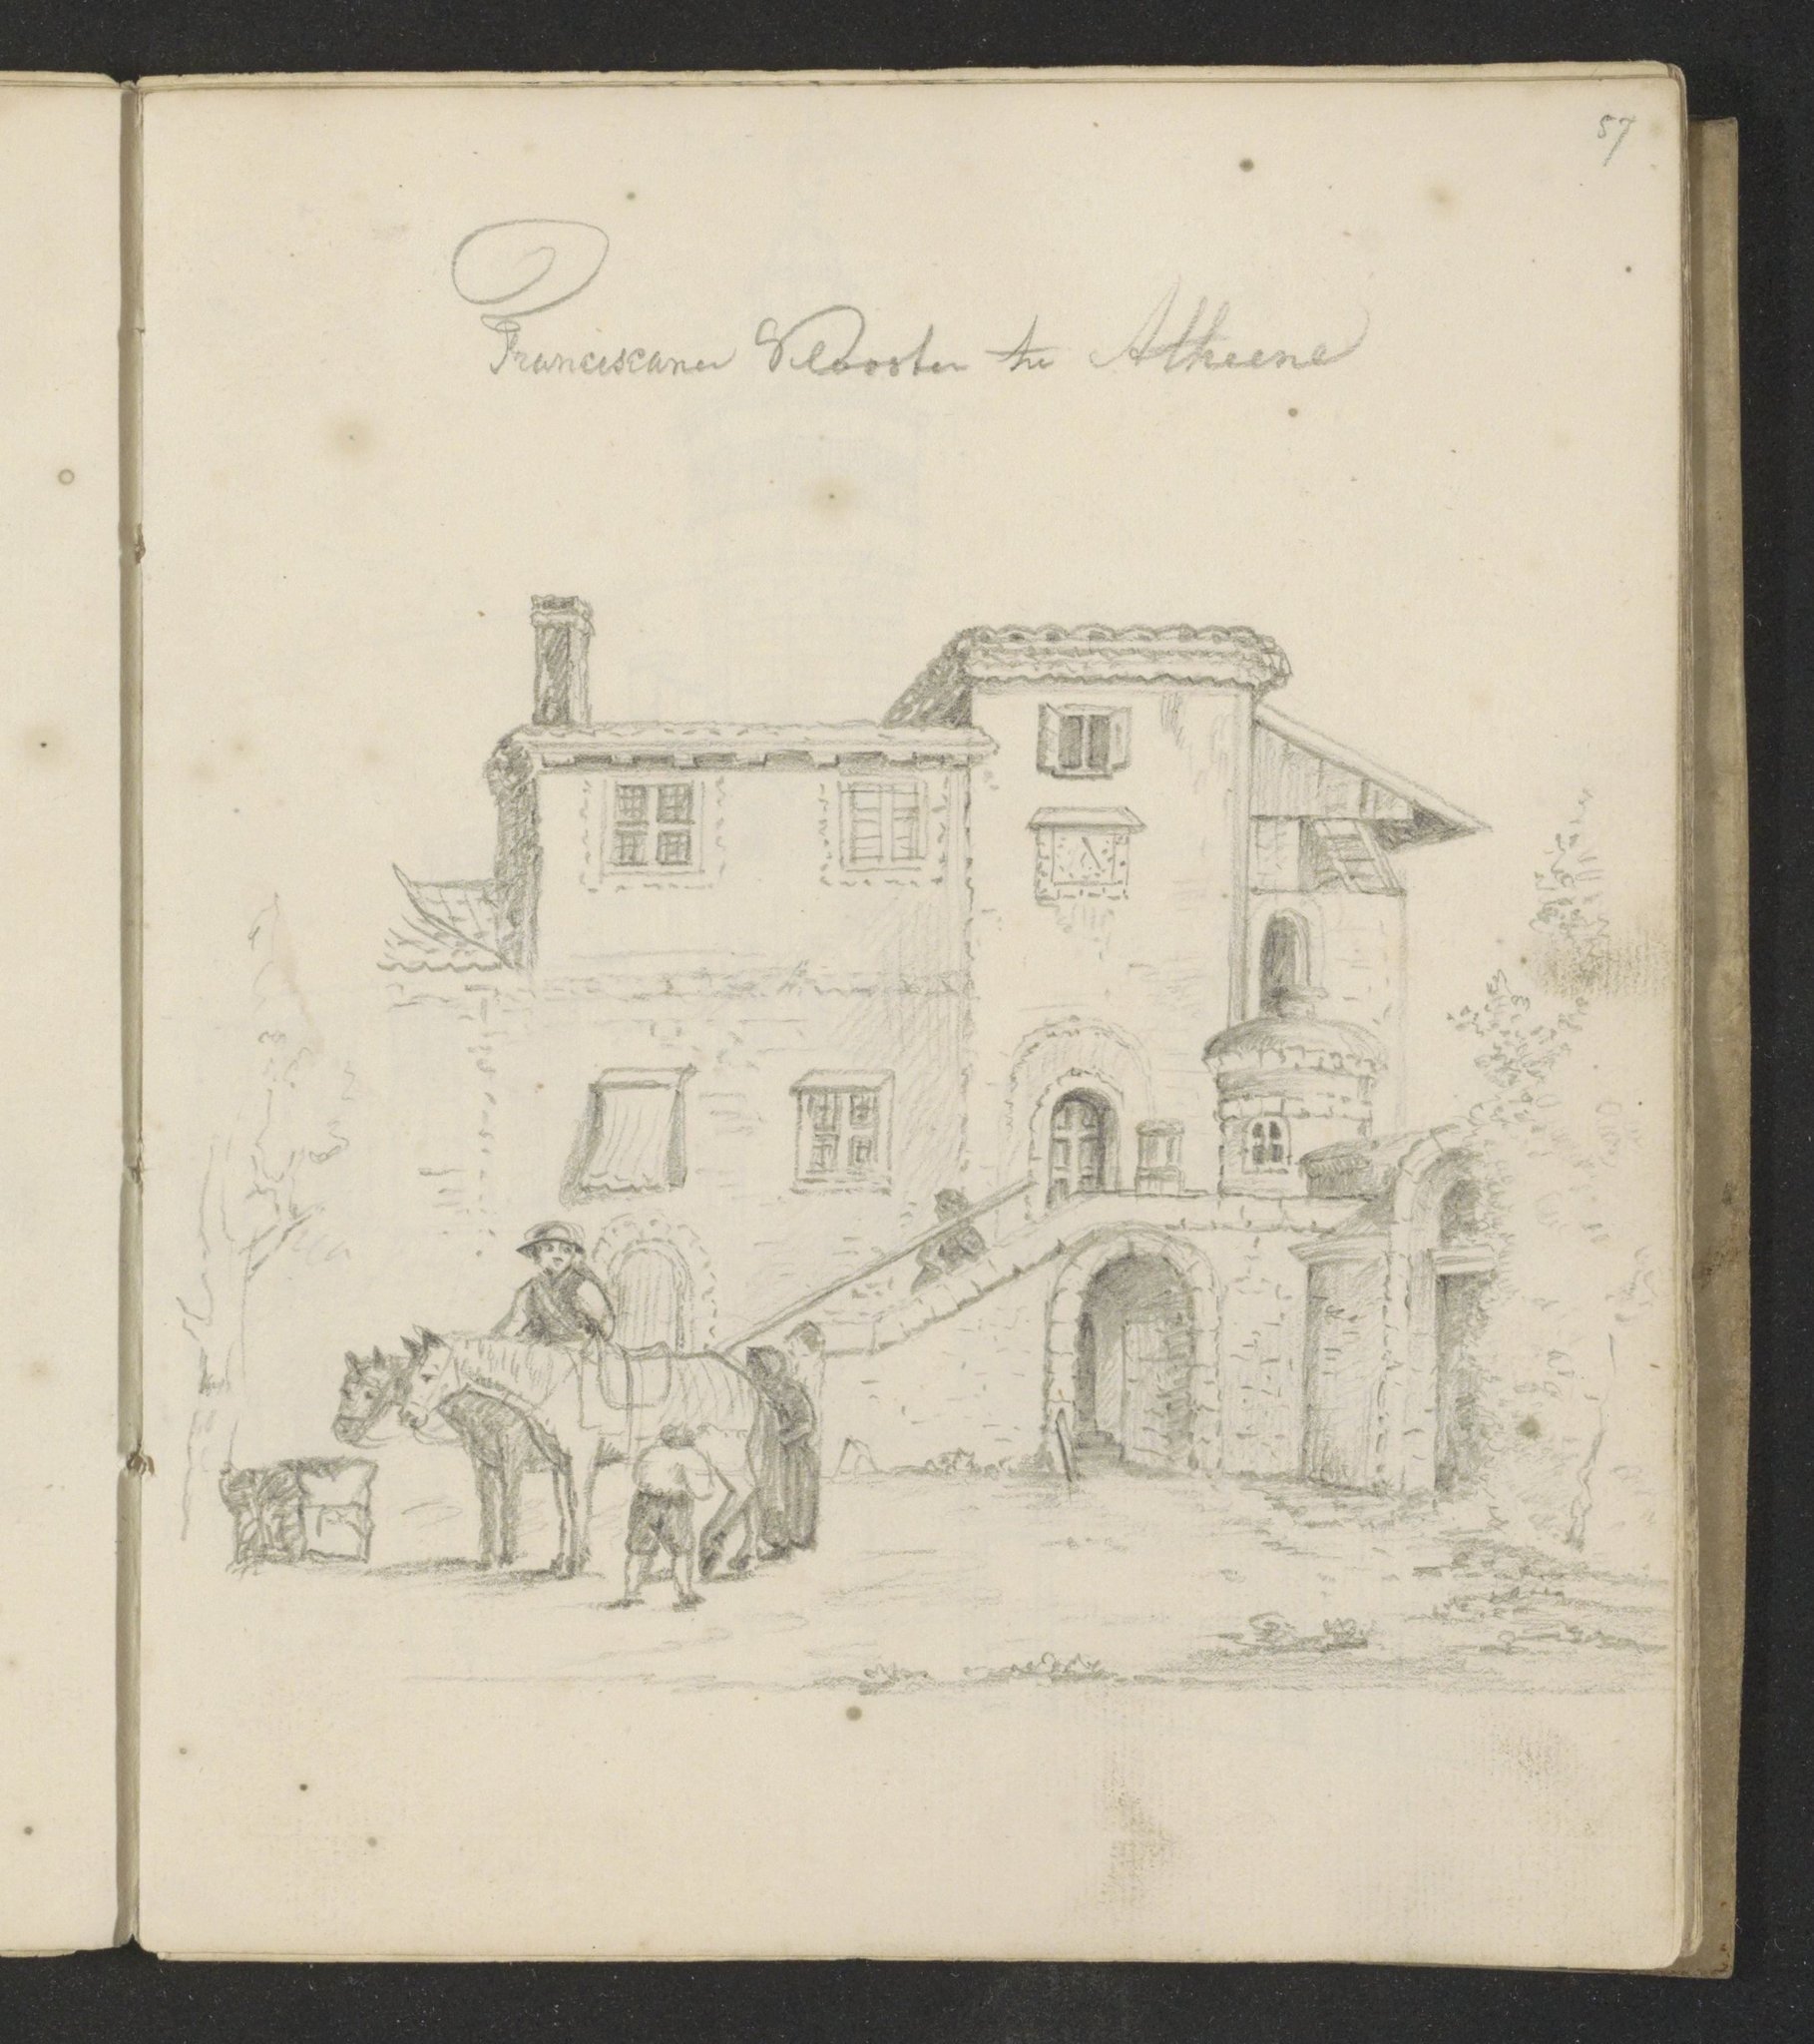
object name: sketchbook leaf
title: Franciscaner klooster te Athene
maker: Anonymous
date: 1840-1860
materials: paper, pencil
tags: cloisters ~ monastery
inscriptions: annotation: ‘Franciscaner klooster te Atheene’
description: Klooster met twee paarden met ruiters bij een drenkplaats op de voorgrond. Bladzijde 57 uit een schetsboek met 96 bladzijden.